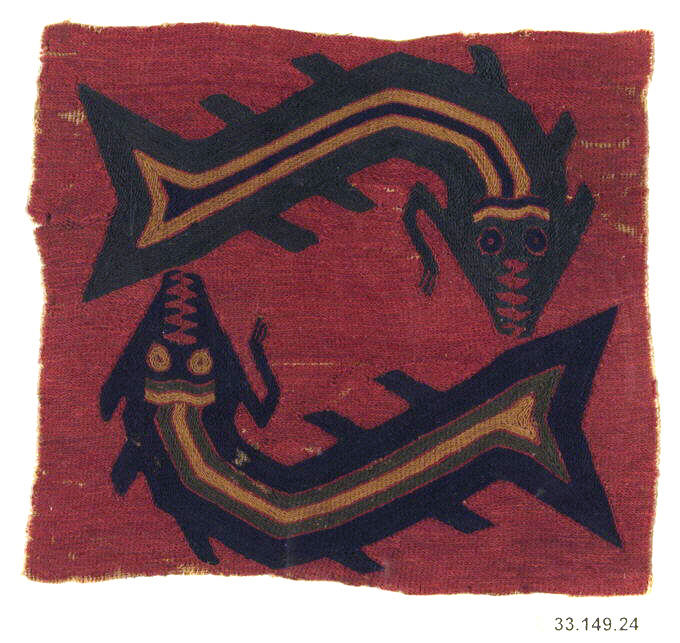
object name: border fragment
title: Embroidered Border Fragment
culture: paracas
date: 400-301 BCE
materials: animal fiber, cotton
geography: peru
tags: fish